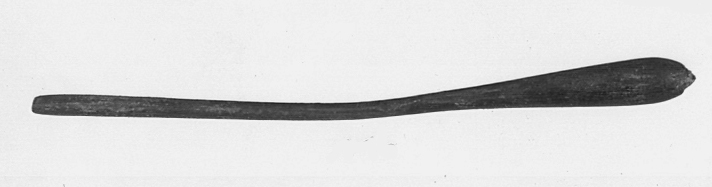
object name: kohl stick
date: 1550-1458 BCE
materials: wood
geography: egypt